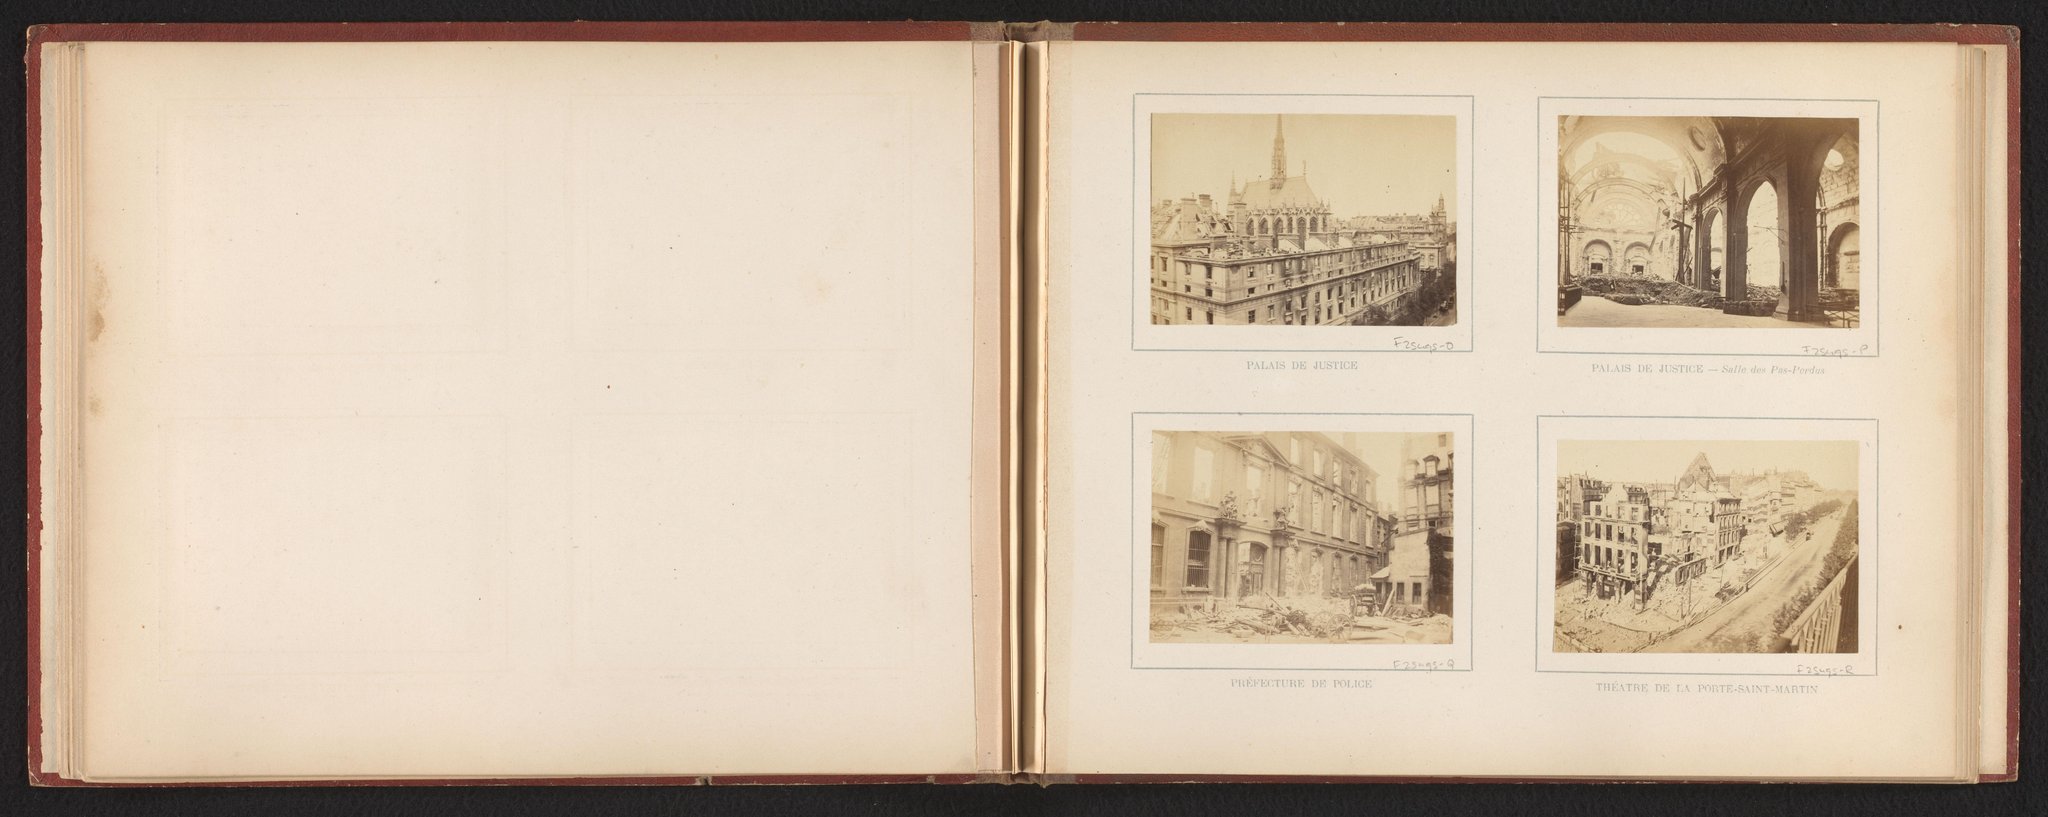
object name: page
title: Gezicht op de verwoeste Politieprefectuur van Parijs na de semaine sanglante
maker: Anonymous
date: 1871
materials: paper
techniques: albumen print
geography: paris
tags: ruin of a building ~ architecture